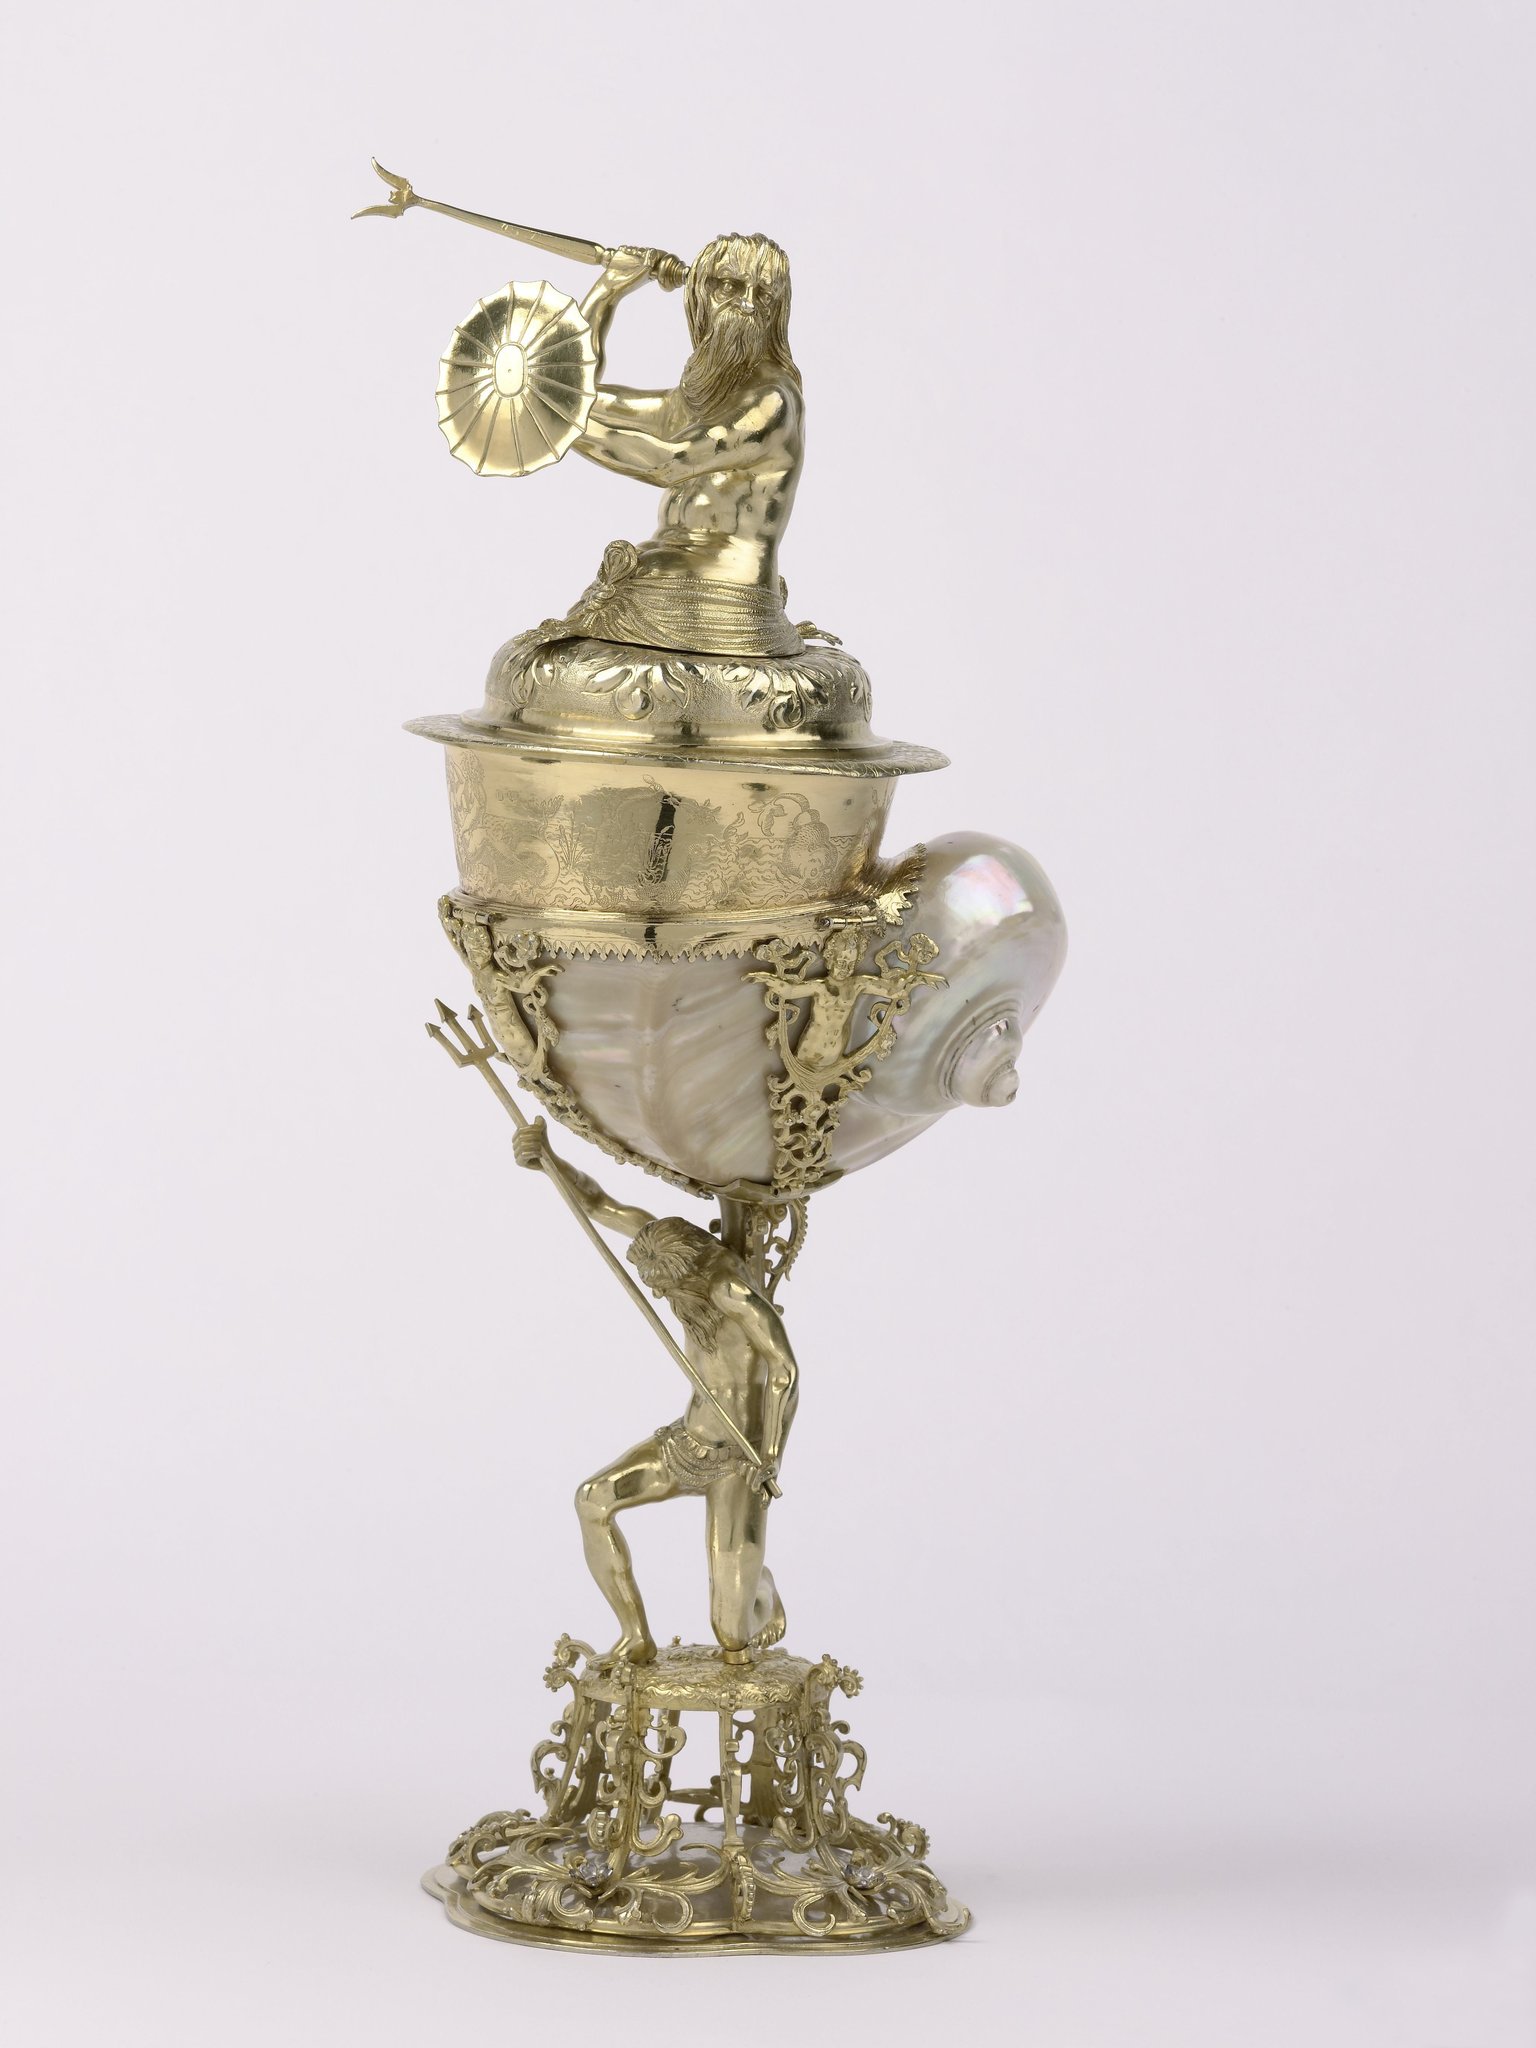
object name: knobbelbeker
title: Turban shell cup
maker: jörg ruel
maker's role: silversmith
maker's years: -1625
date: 1600-1625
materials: shell, silver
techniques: etching, gilding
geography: nuremberg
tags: (story of) neptune (poseidon), offspring, companion(s), train etc. of neptune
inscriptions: maker's mark: ‘IR (Rosenberg III, nr. 4086).’, town mark: ‘N’, initials: ‘GB’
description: Knobbelhoornbeker met verguld zilveren montuur. Op het gewelfde deksel met gedreven bladwerk een triton ten halven lijve met harpoen in de rechterhand en een schild in de linkerhand. De schelp wordt gedragen op de rug van een knielende Neptunus, die een drietand met beide handen vasthoudt. Het voetstuk bestaat uit opengewerkte, gestileerde ranken, waarop een plaat rust met gedreven golven. De schelp is gevat in figurale klampen met rolwerk; de mondrand is omgeven door een breed boord met geëtste voorstellingen van vechtende en vrijende tritons, een nereïde en zeemonsters. In het deksel het wapen van Backer, geplaatst op een uitgeslepen, reeds aanwezig wapenschild. Onder de bodemplaat hetzelfde wapen, een huismerk en de initialen GB.